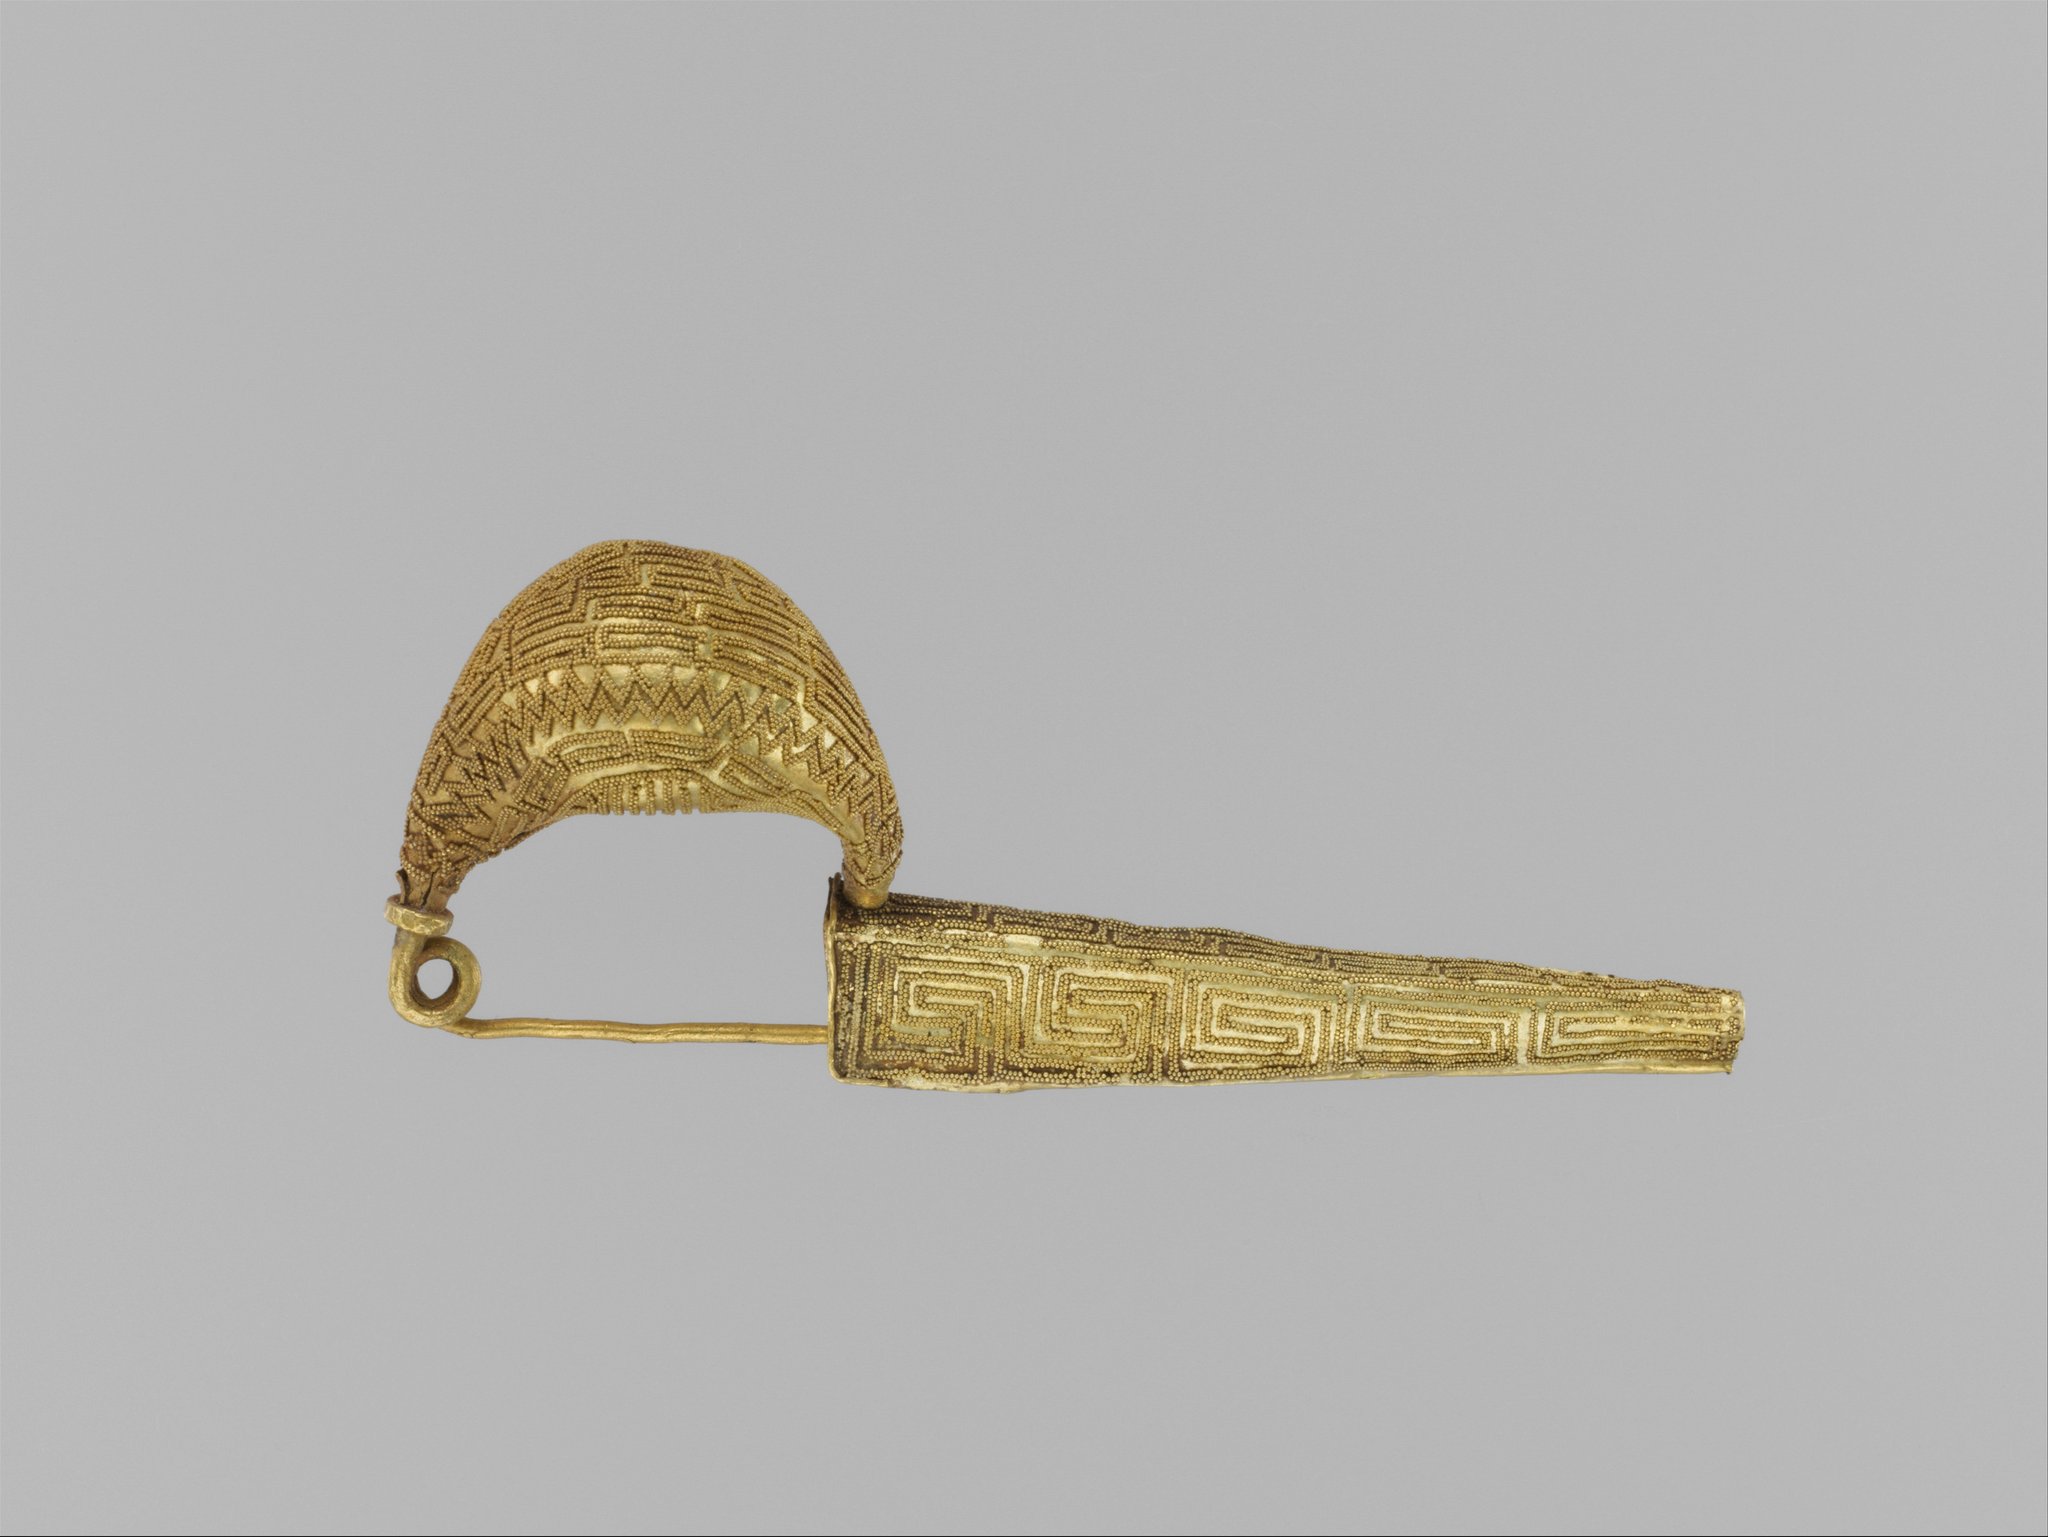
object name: fibula, leech shaped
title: Gold sanguisuga-type fibula (safety pin) with patterns in granulation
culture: etruscan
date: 700-601 BCE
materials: gold